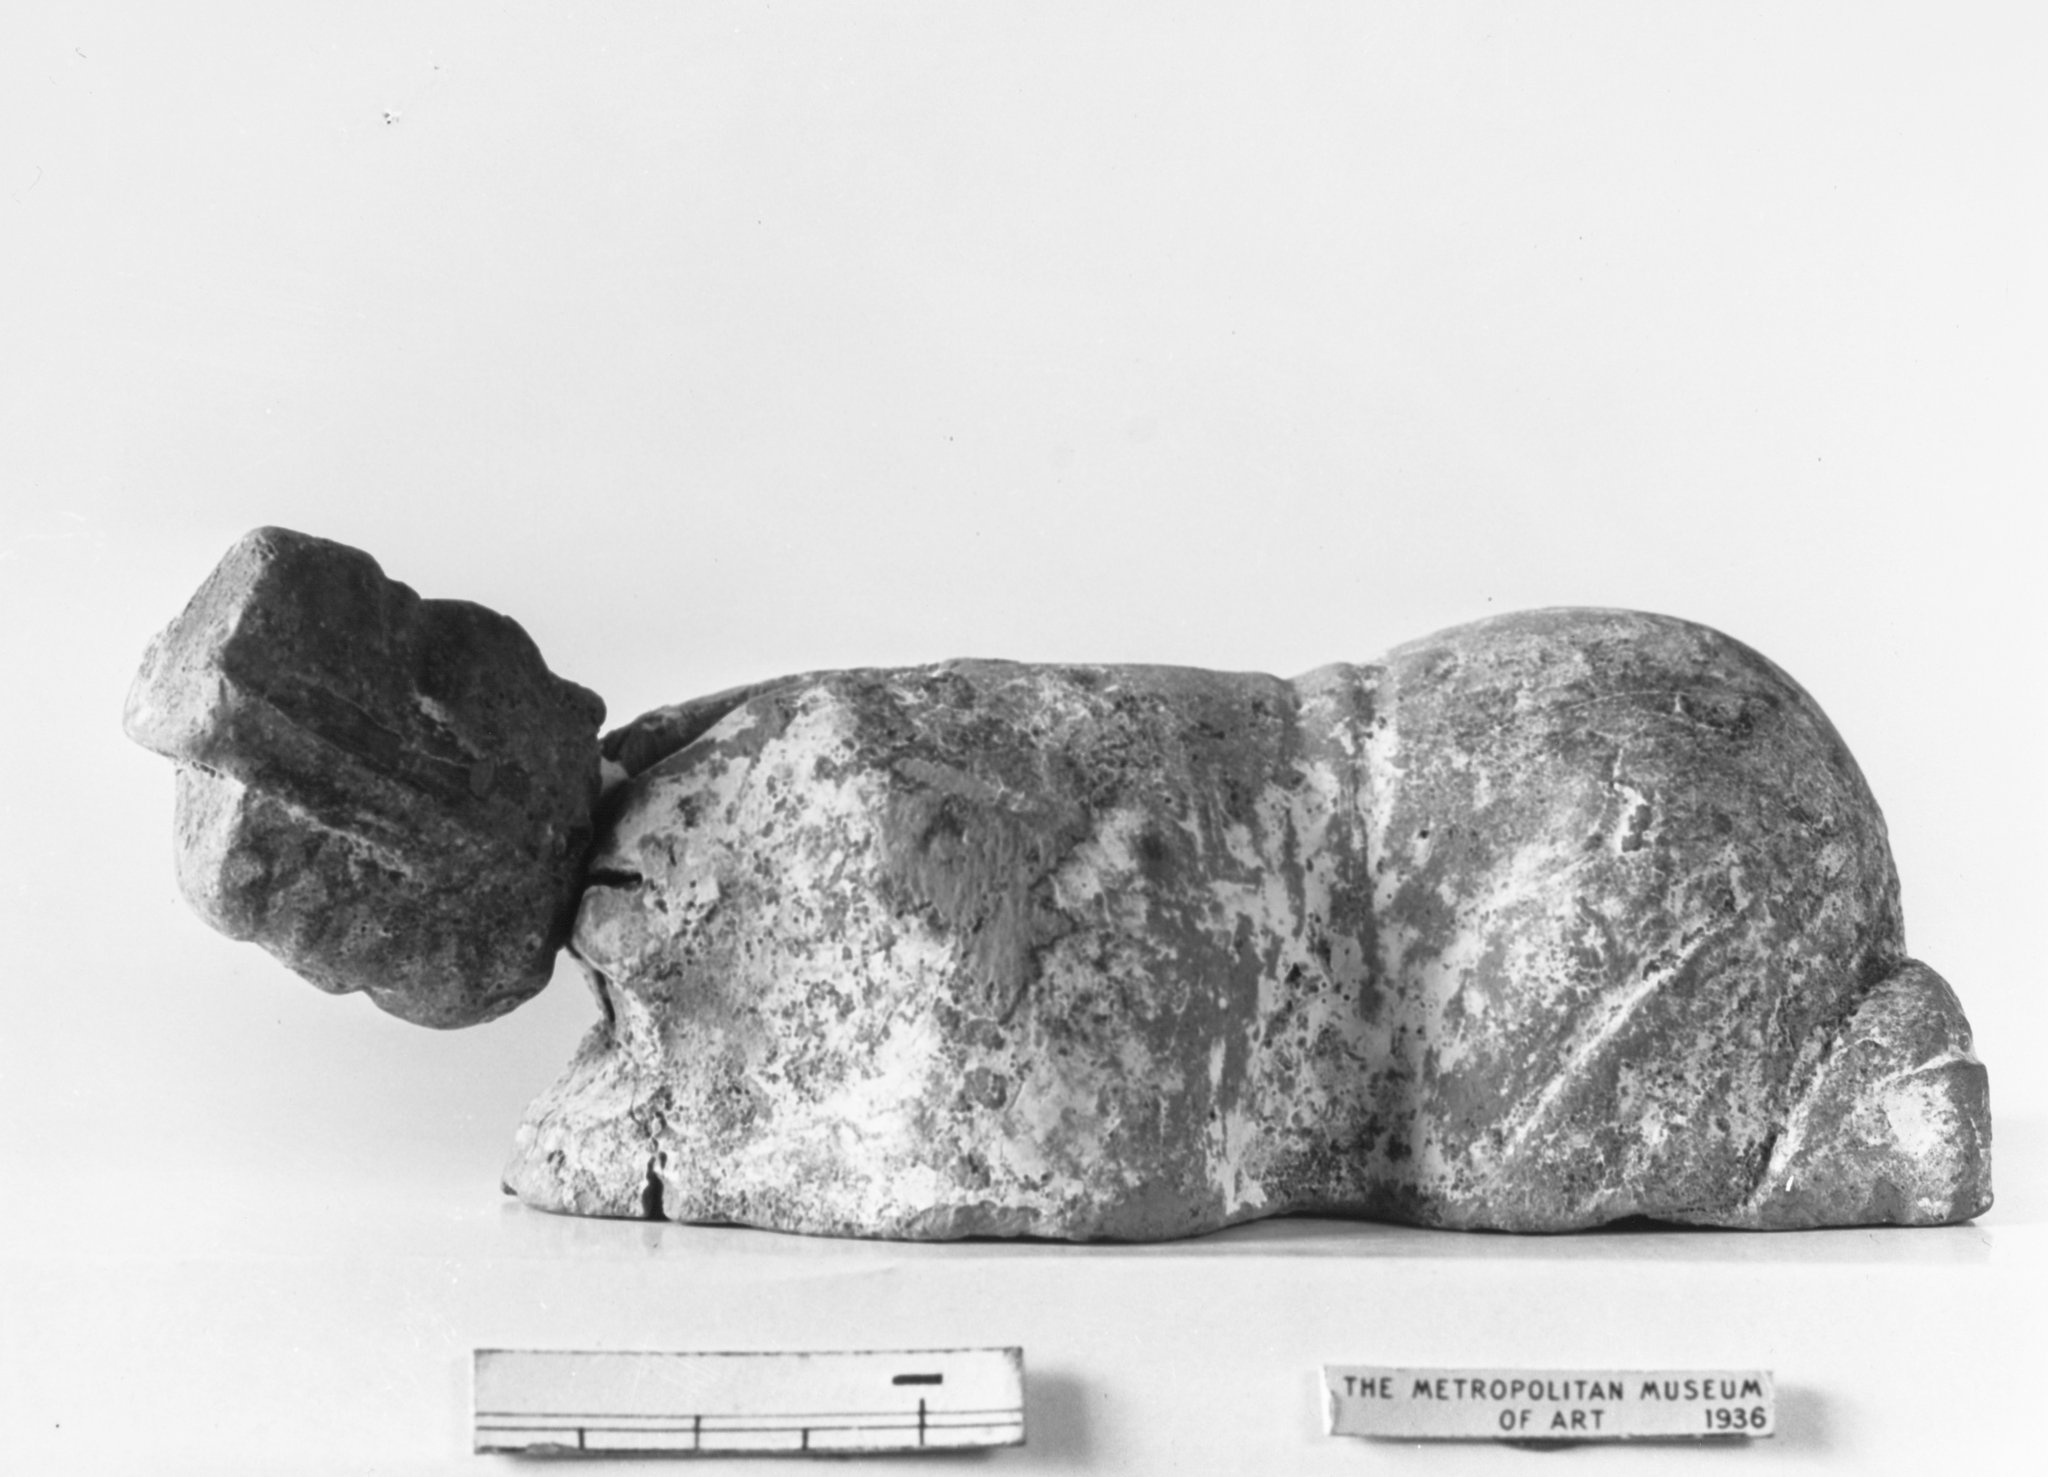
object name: kowtowing figure with movable head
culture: chinese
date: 206 BCE-220 CE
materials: pottery